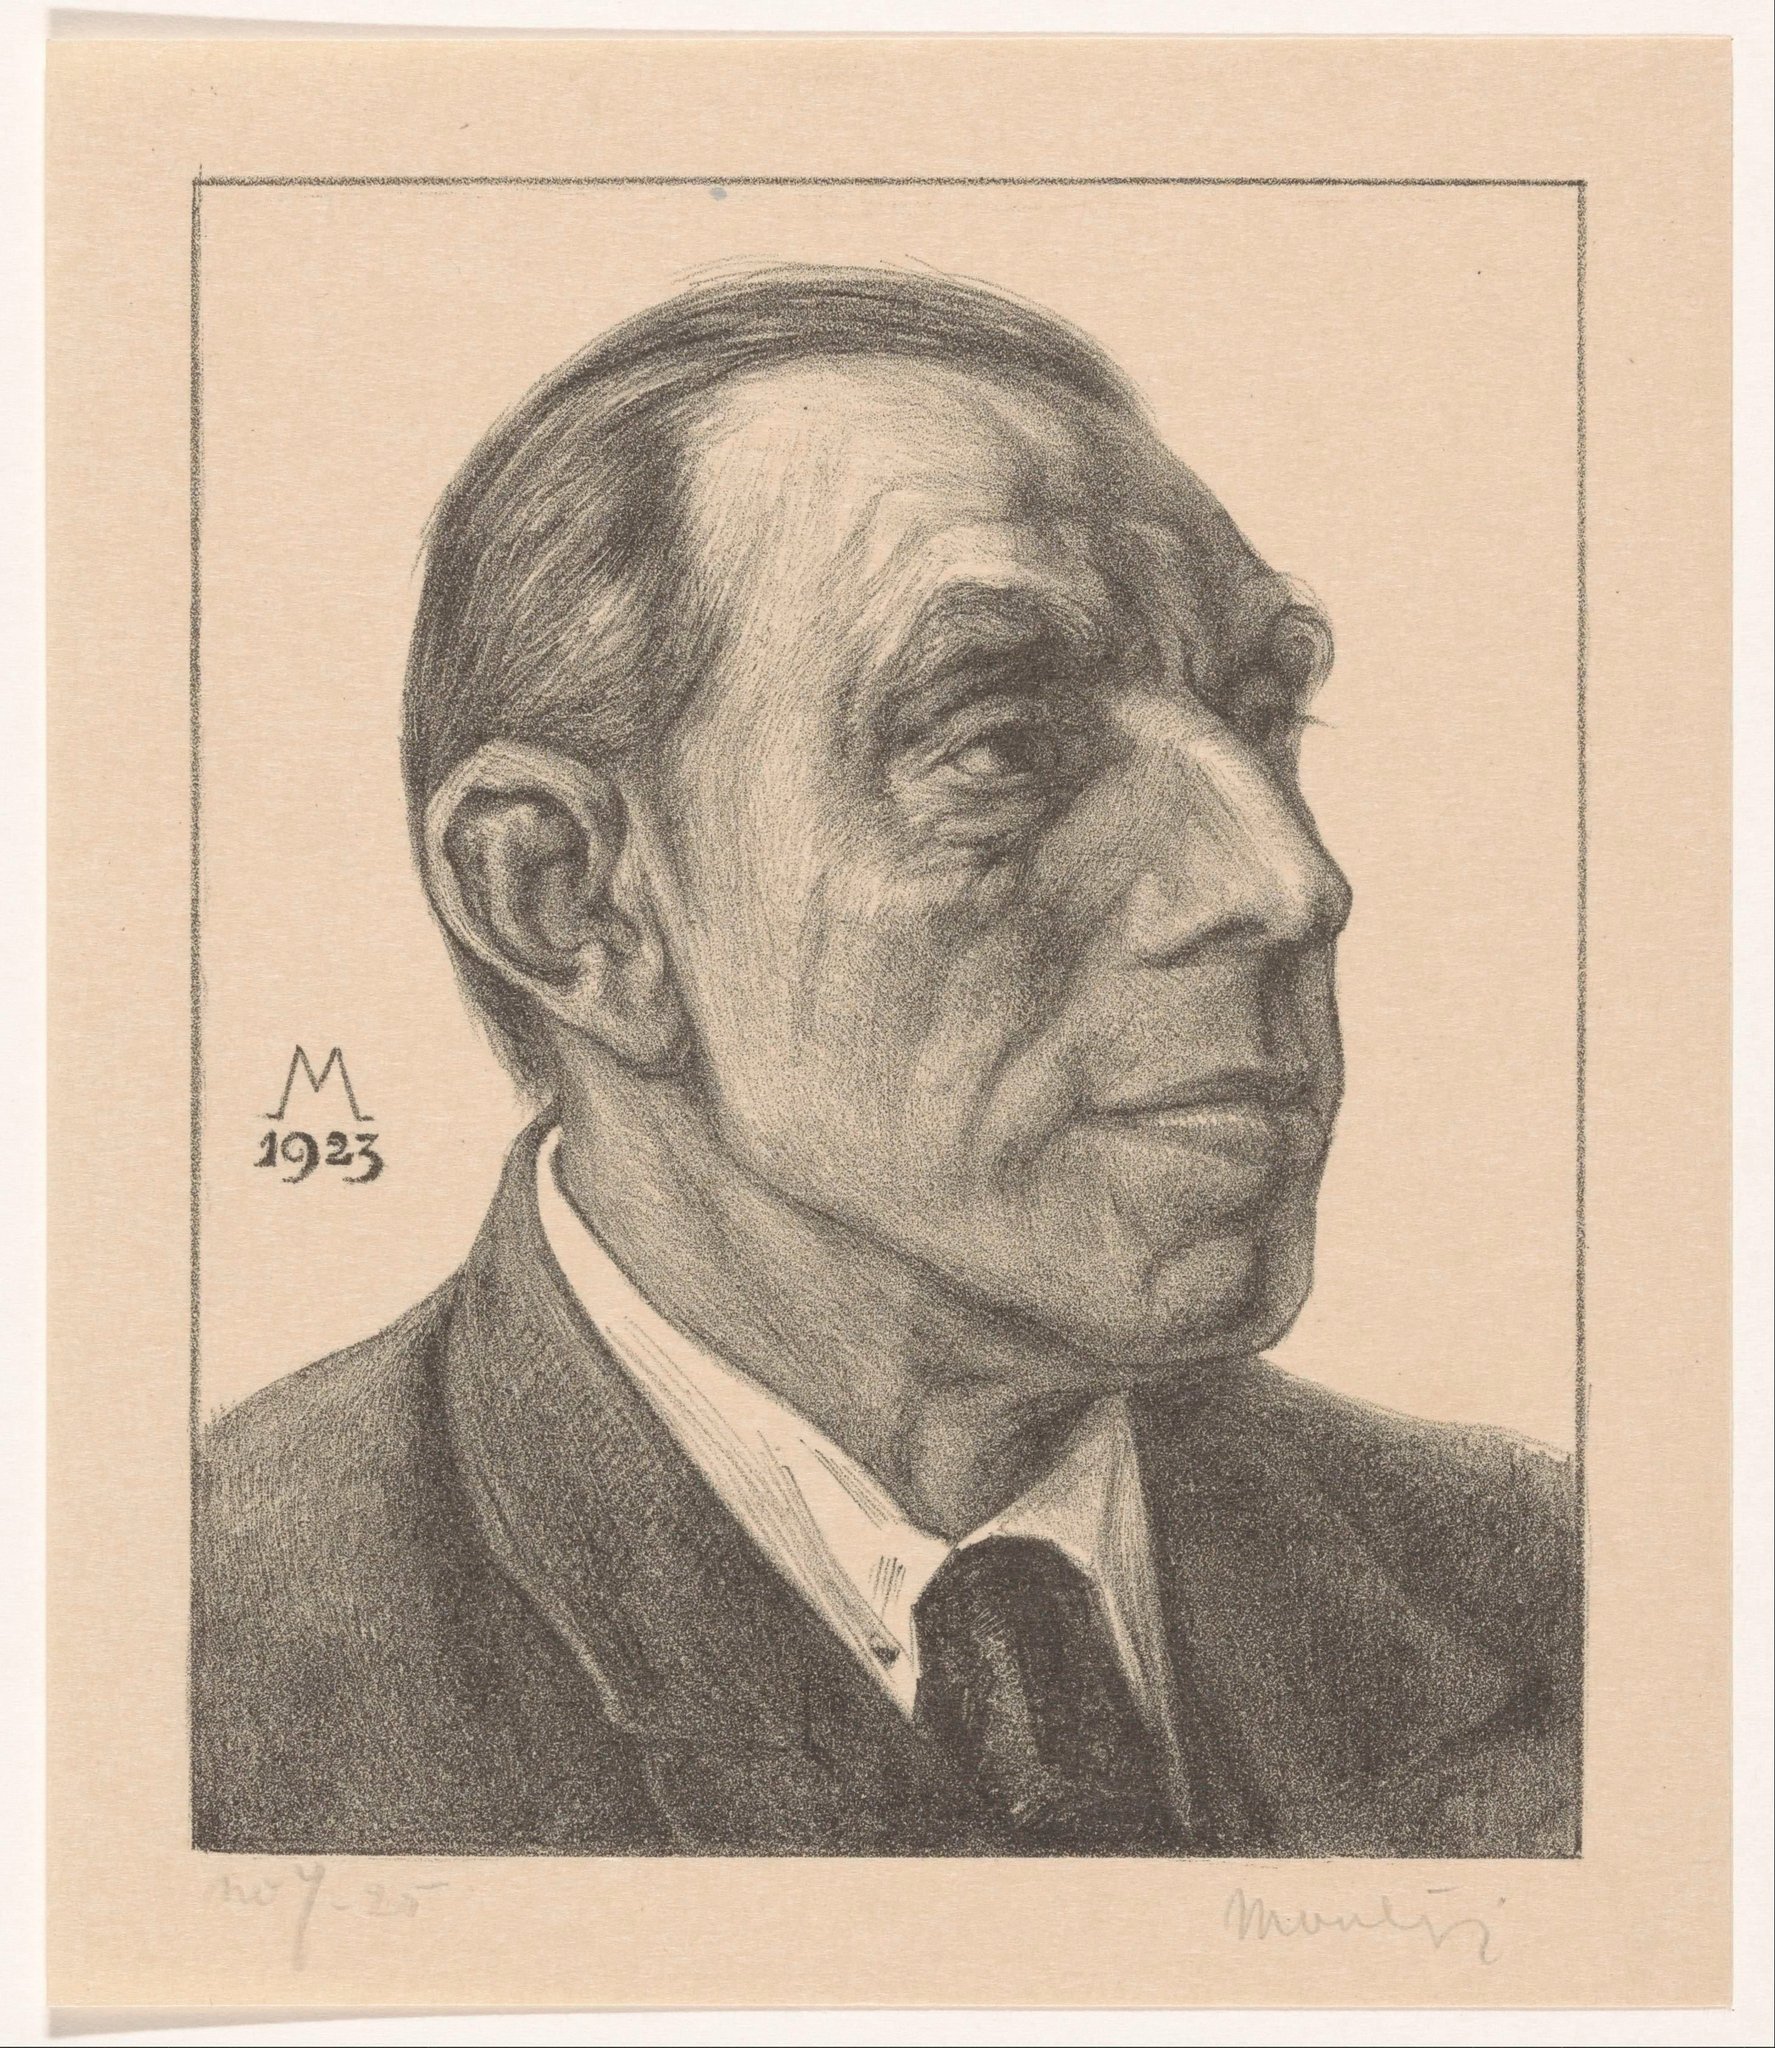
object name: print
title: Portret van Hendricus Petrus Bremmer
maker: simon moulijn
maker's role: draughtsman, print maker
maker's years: 1866-1948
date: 1923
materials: paper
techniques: lithograph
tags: leiden, the hague, print maker, hendricus petrus bremmer, historical persons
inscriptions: collector's mark: Lugt 2228